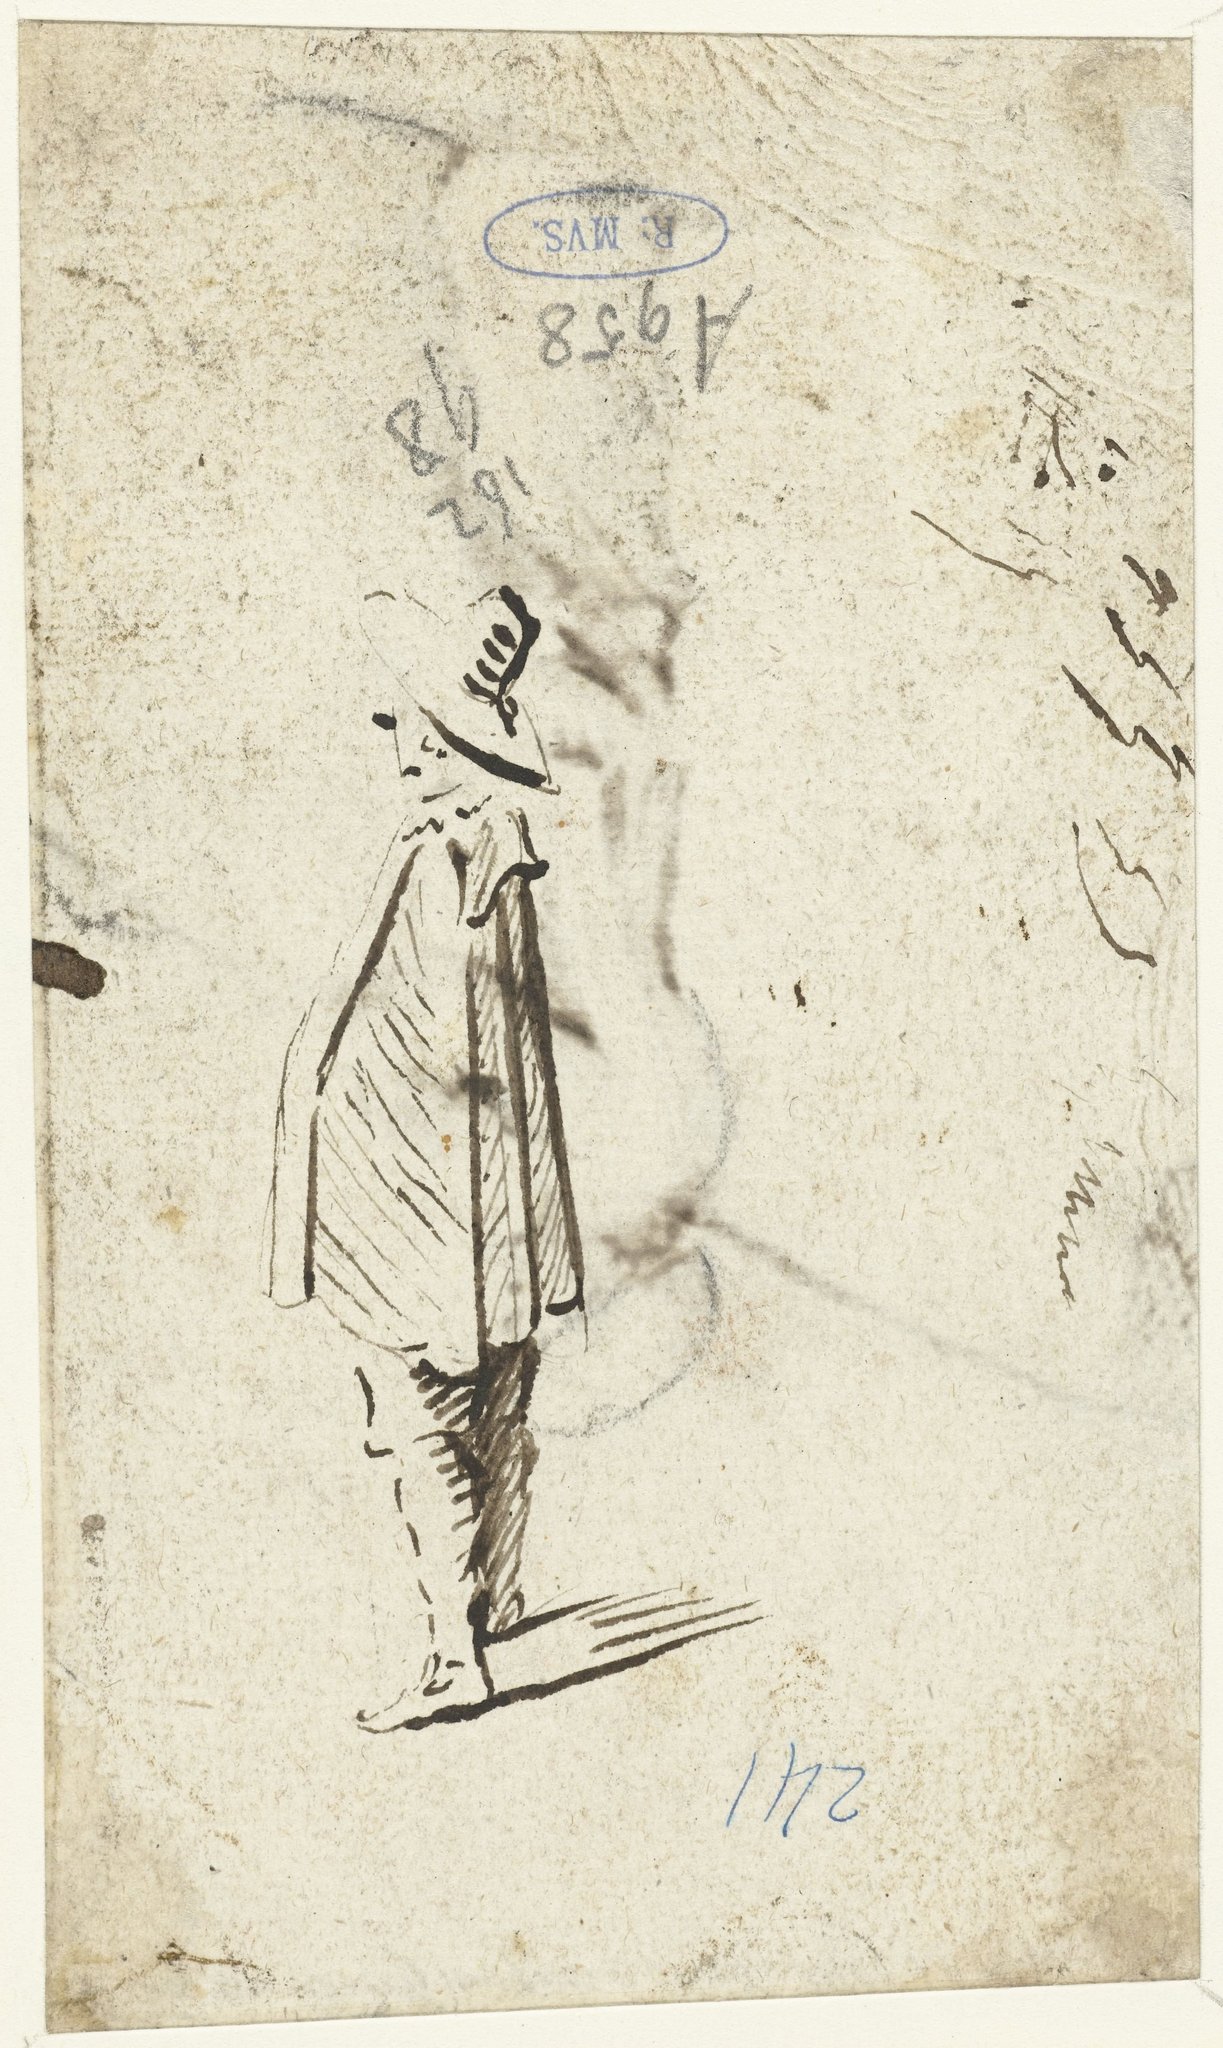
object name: drawing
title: Man in een cape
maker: harmen ter borch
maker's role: draughtsman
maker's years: 1638-1677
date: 1649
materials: ink, paper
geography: zwolle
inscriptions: date